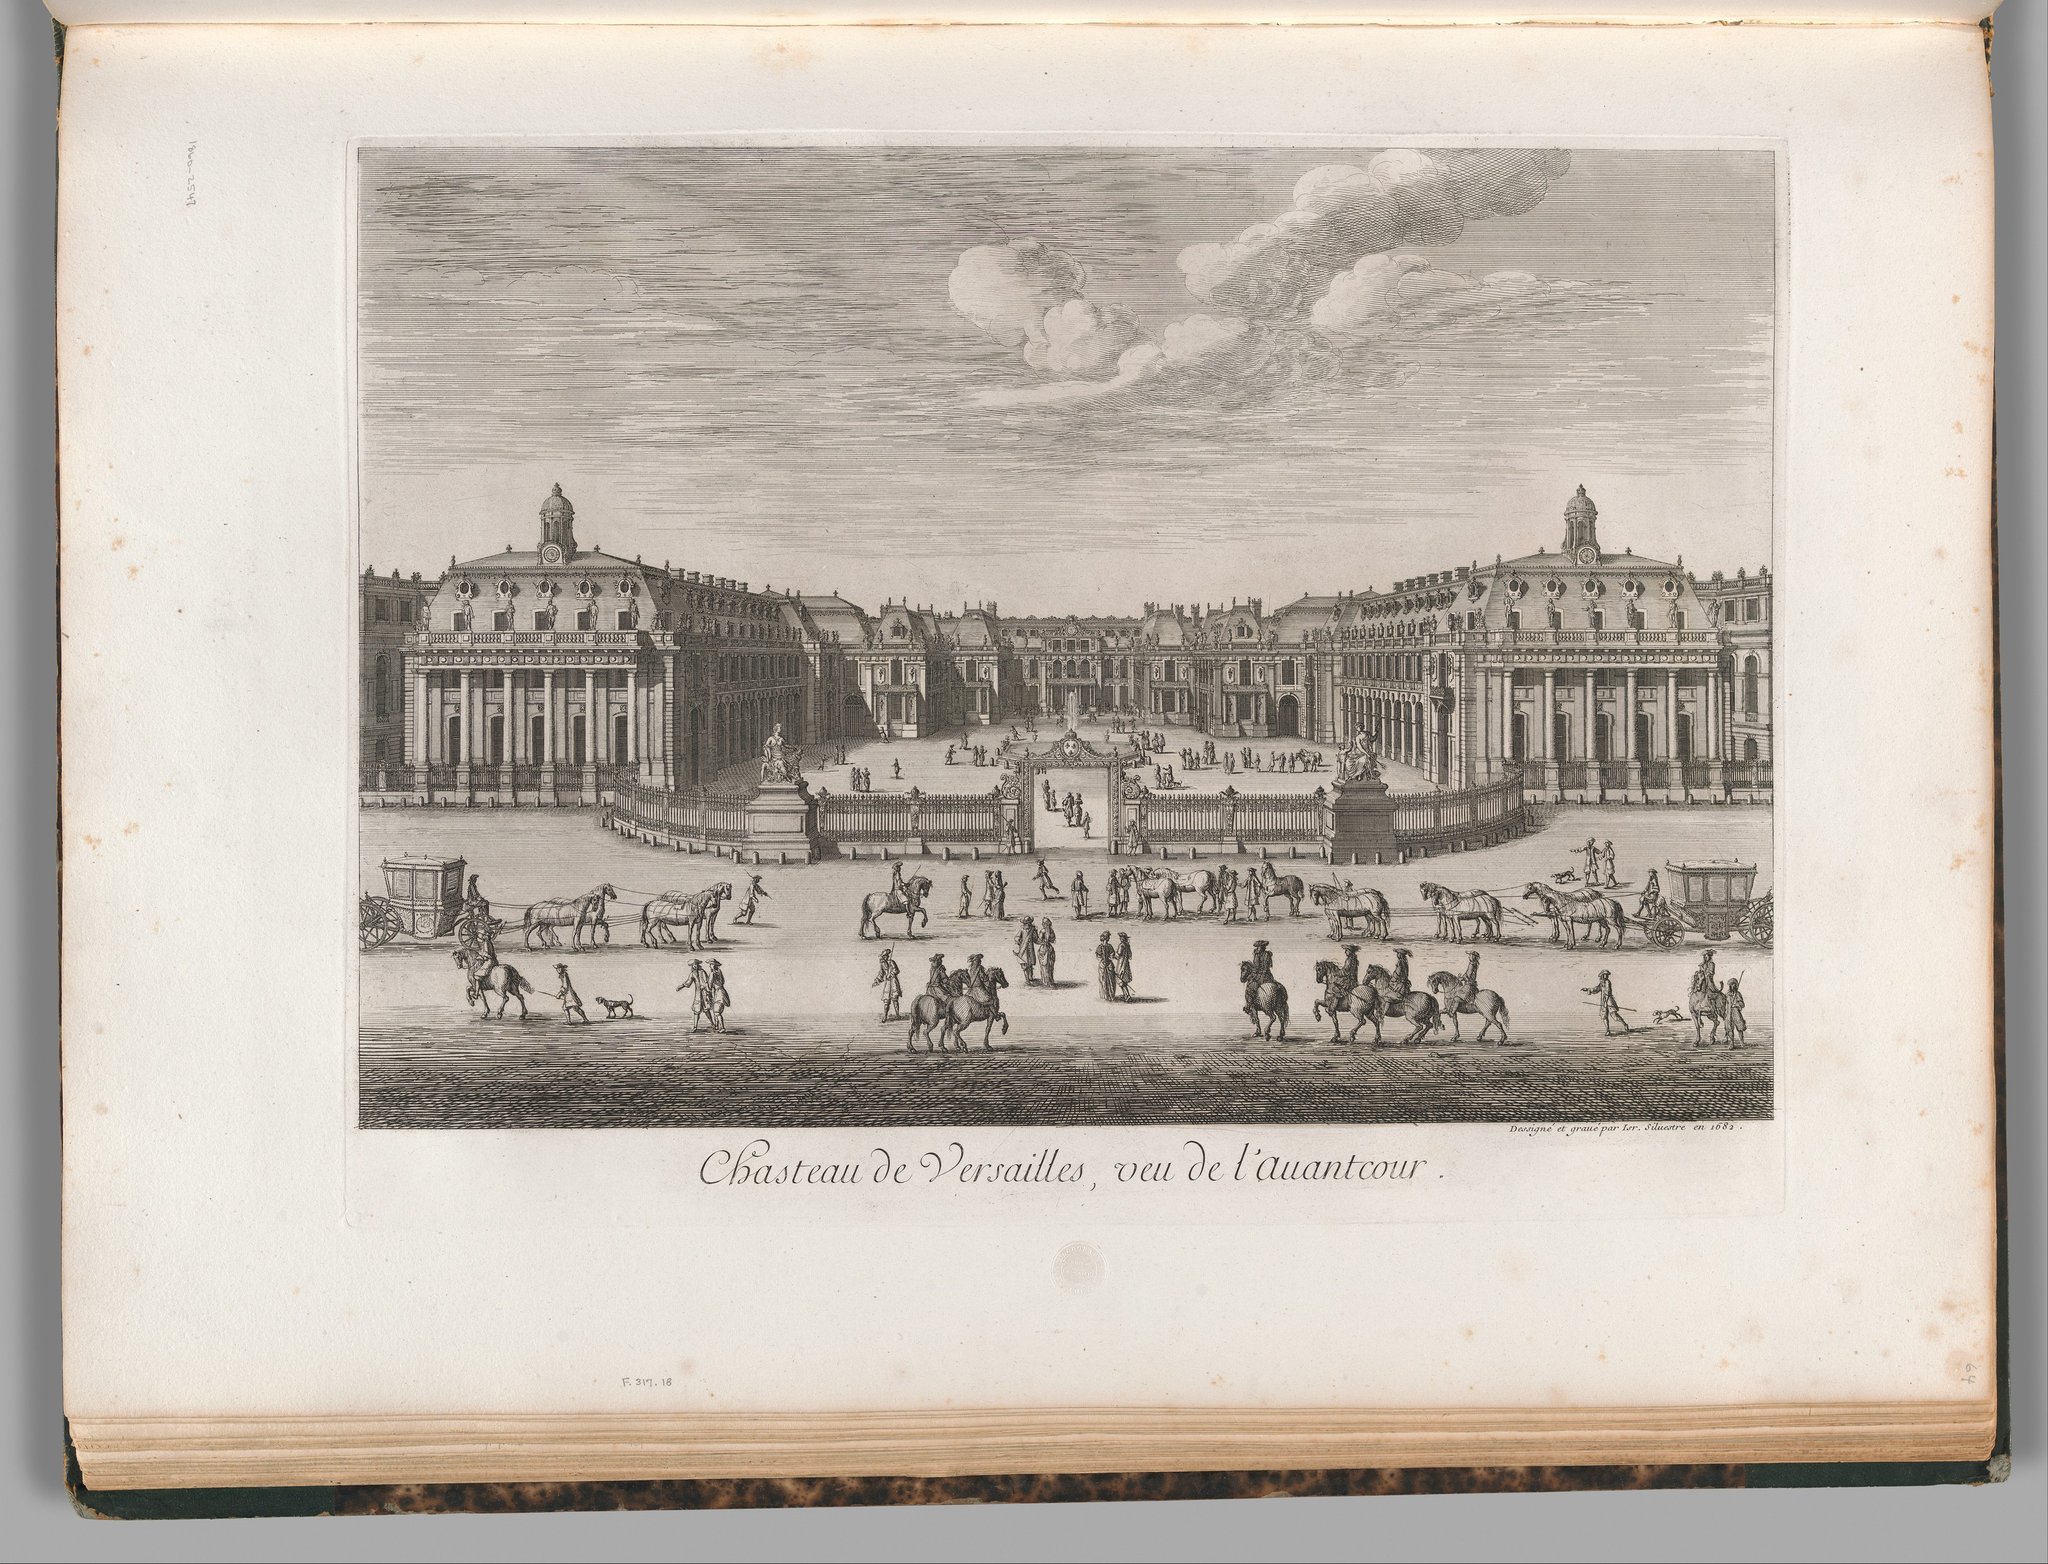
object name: book print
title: Château de Versailles seen from the forecourt, from Chalcographie du Louvre, Vol. 22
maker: israël silvestre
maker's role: artist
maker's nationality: french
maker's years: 1621-1691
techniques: etching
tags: architecture,palaces